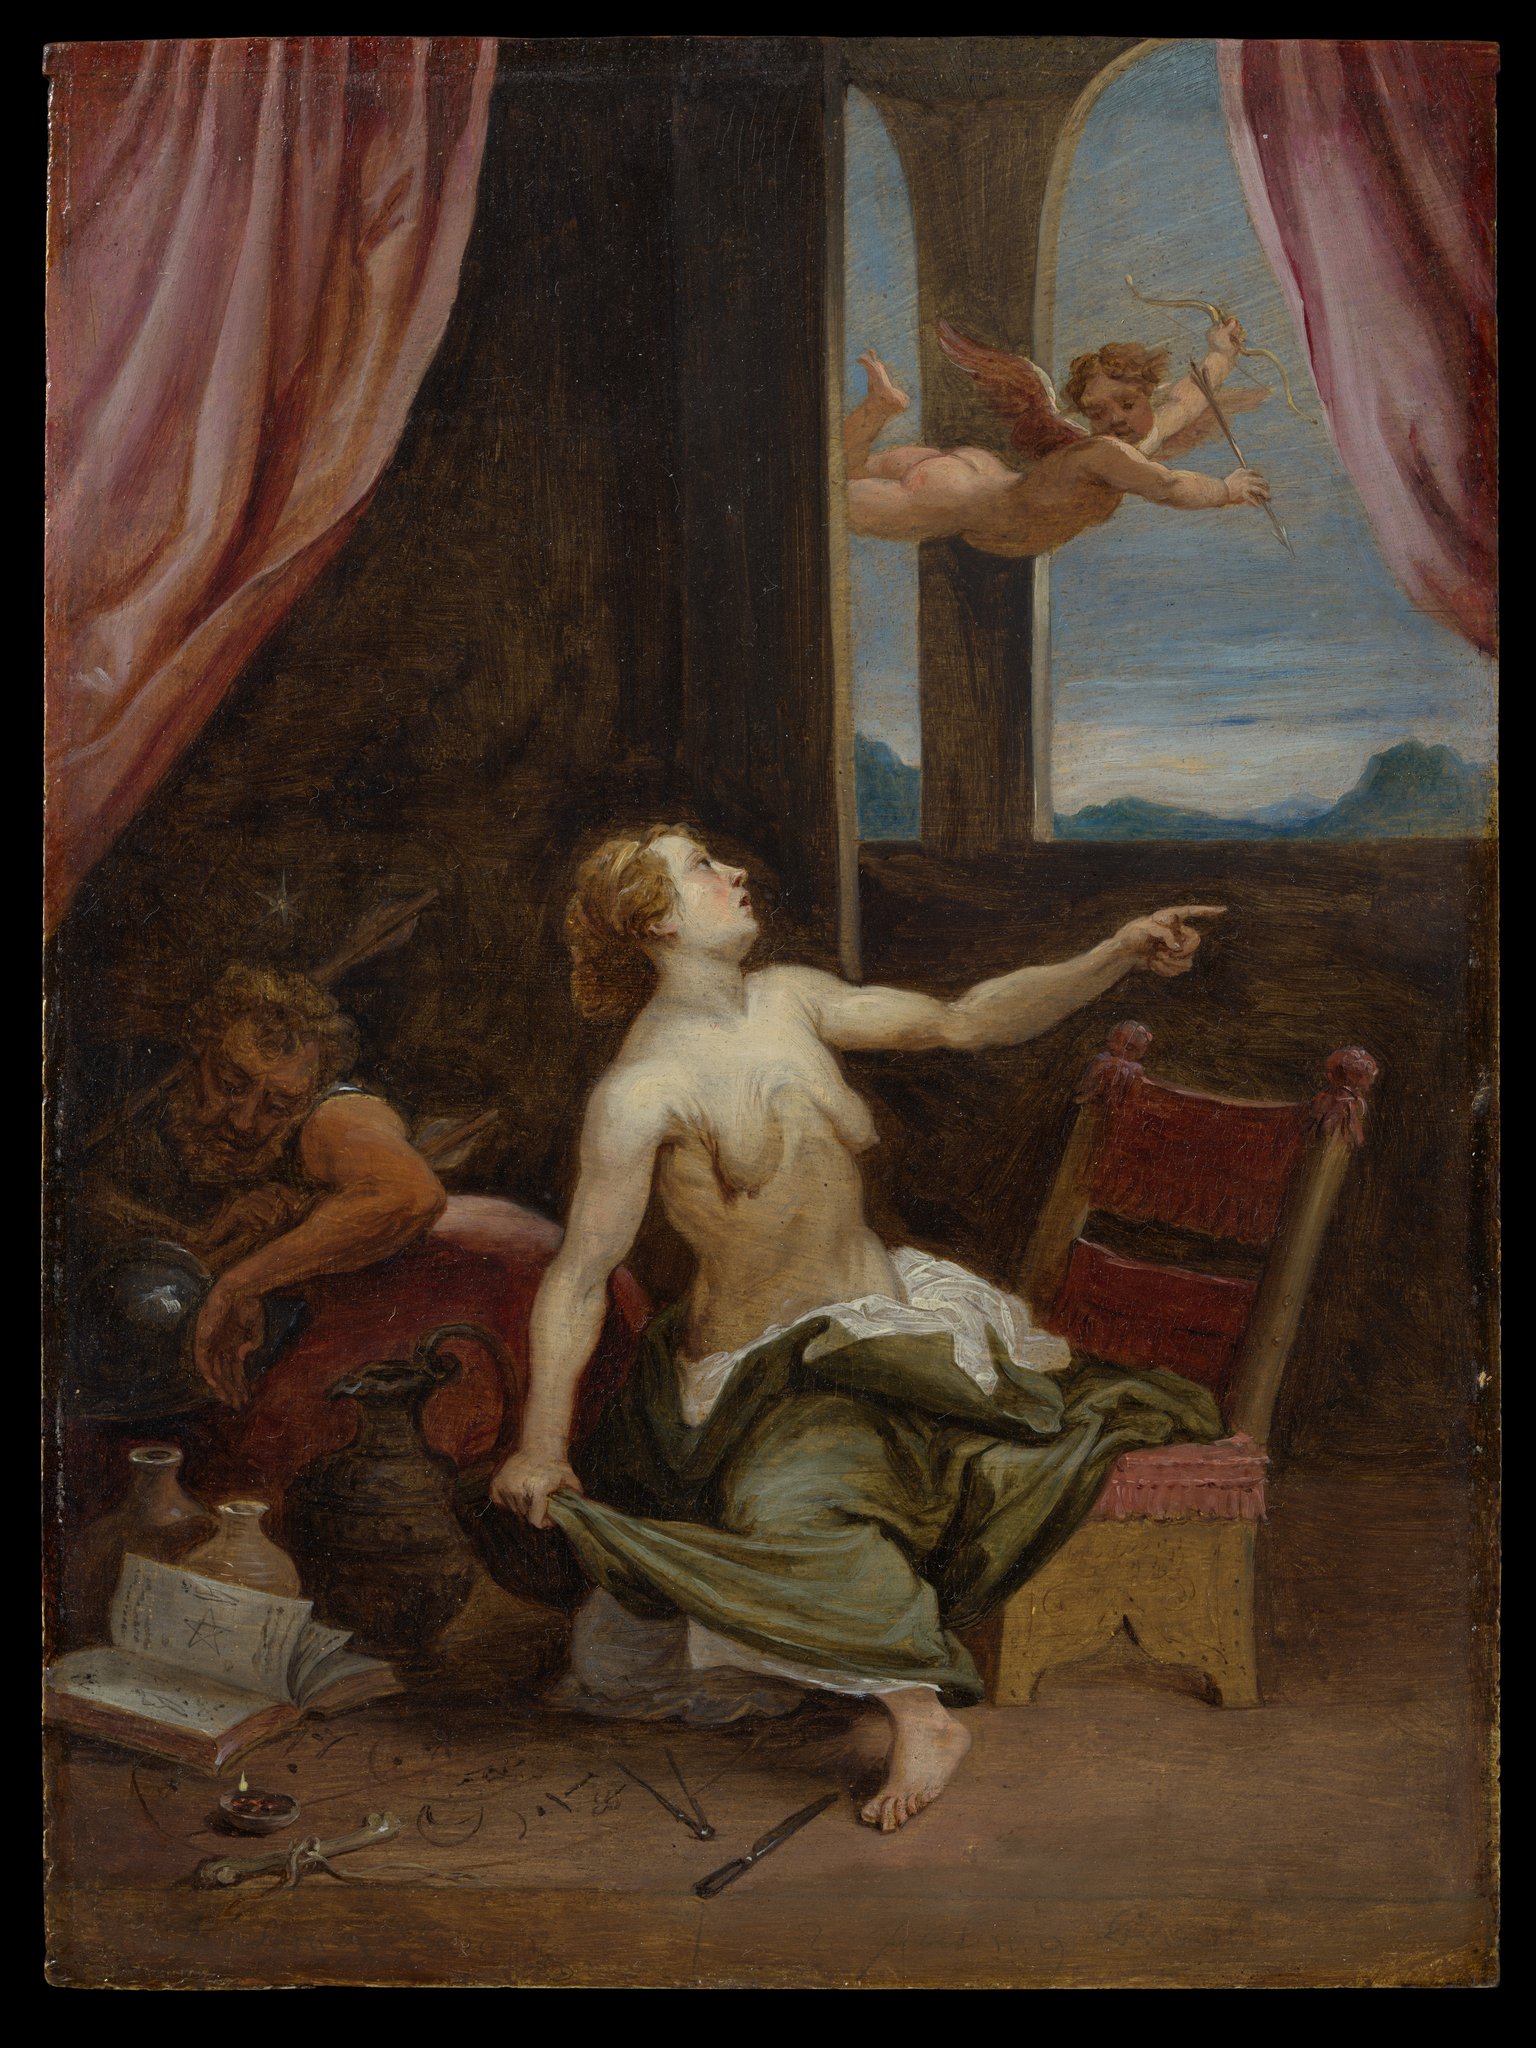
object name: painting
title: Old Age in Search of Youth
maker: david teniers the younger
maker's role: artist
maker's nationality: flemish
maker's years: 1610-1690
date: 1650-1659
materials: oil, panel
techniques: drawing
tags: men,female nudes,putti